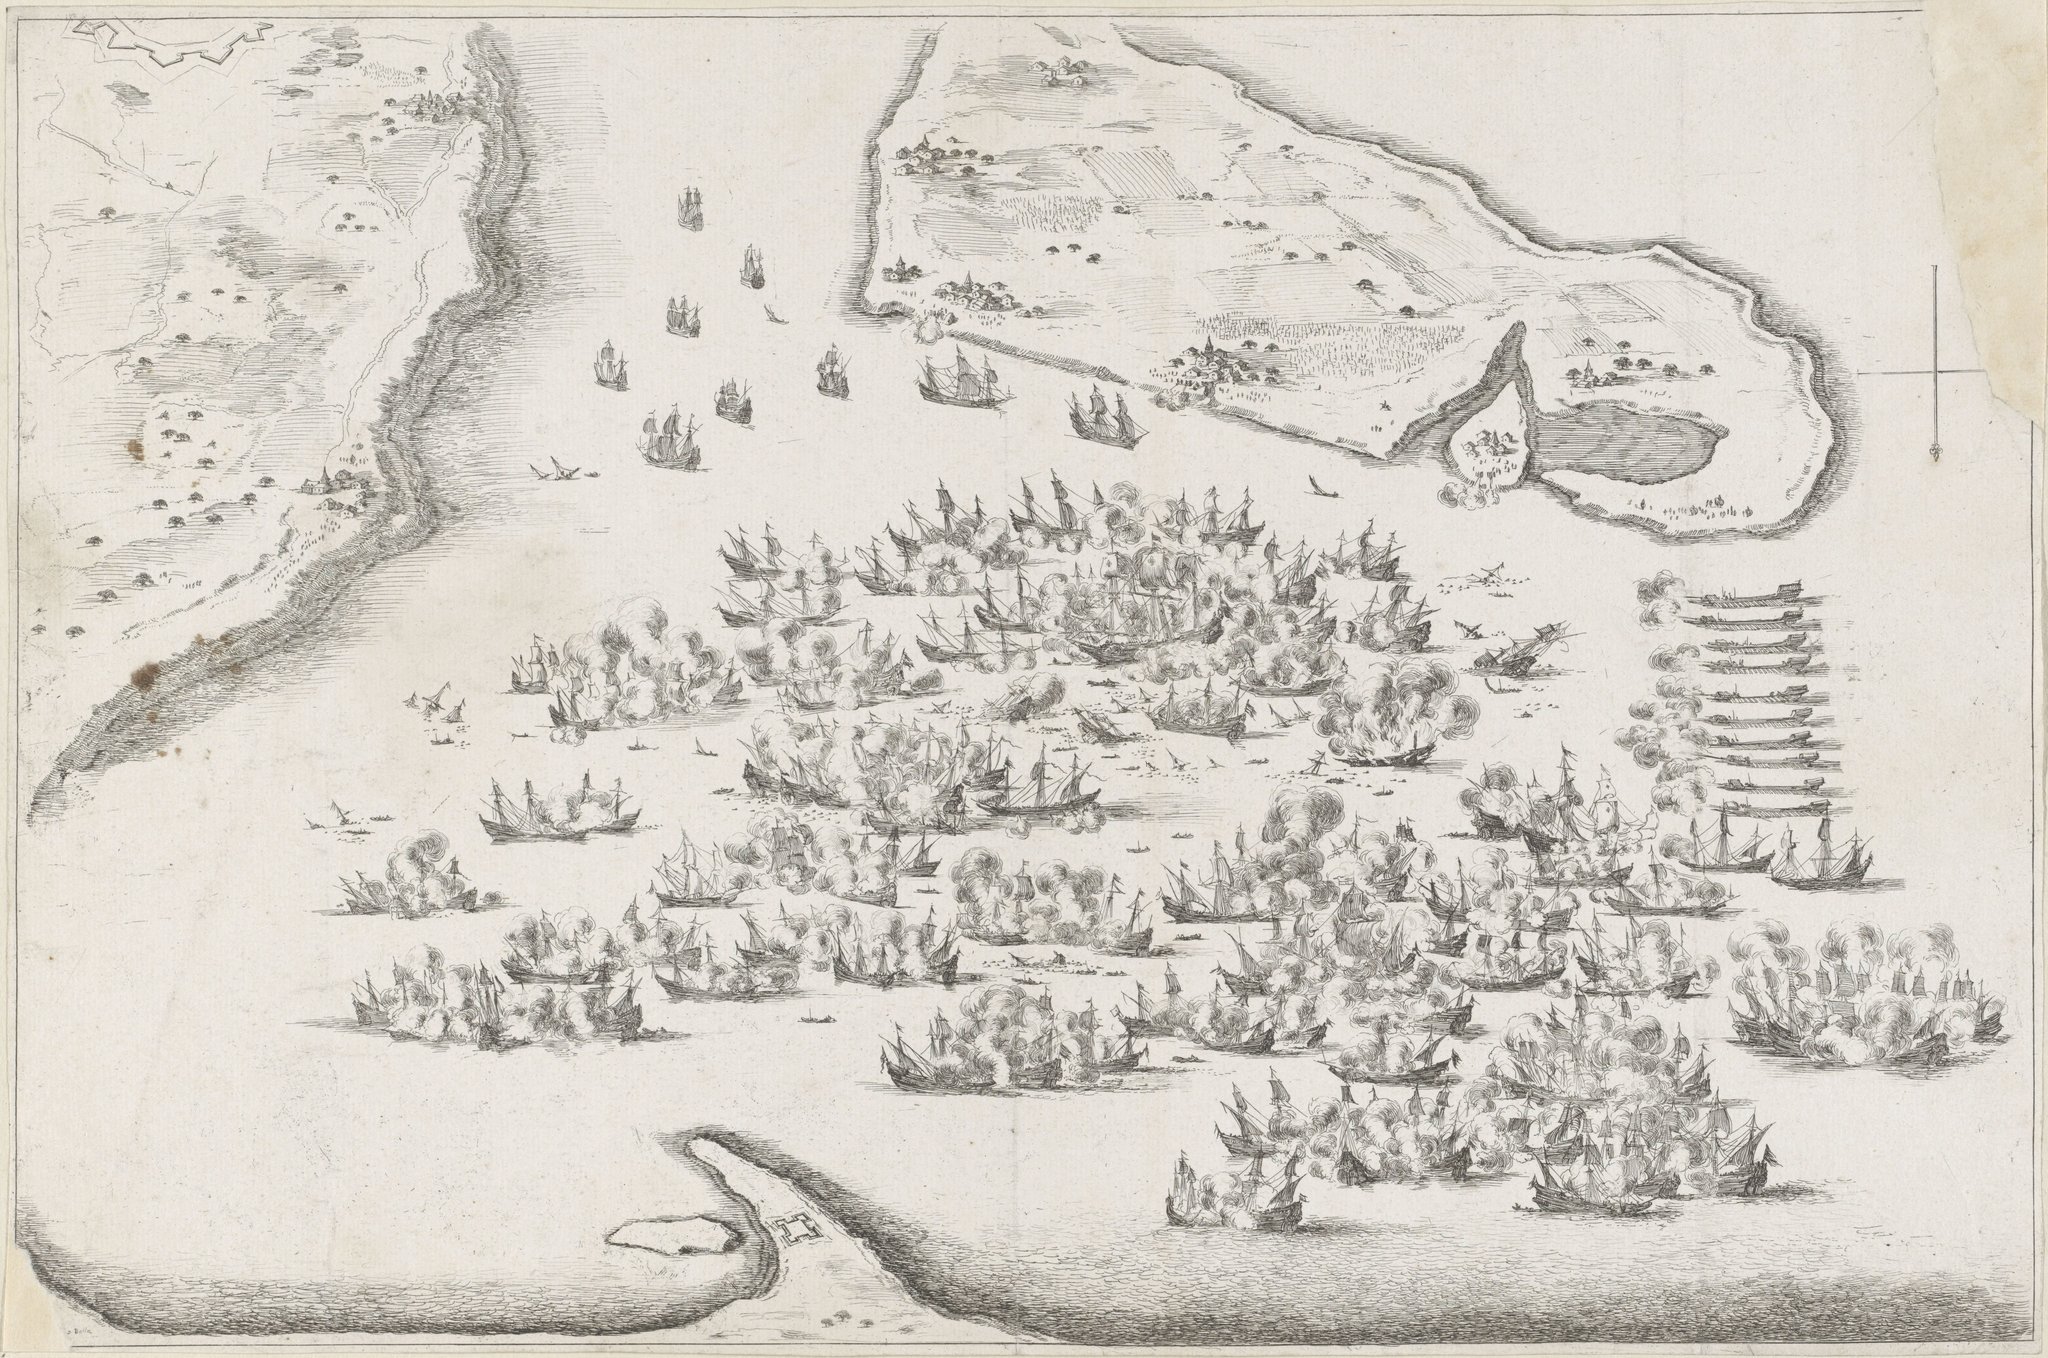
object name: print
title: Illustraties voor: Jean Valdor, Les triomphes de Louis le Juste XIII du nom, 1649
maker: stefano della bella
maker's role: draughtsman, print maker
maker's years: 1610-1664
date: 1620-1664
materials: paper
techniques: etching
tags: battle (+ sailing-ships)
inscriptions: collector's mark: Lugt 240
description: De zeeslag bij La Rochelle op 22 juni 1372 tussen de Engelse vloot onder leiding van de Graaf van Pembroke tegen de geallieerde vloot van Frankrijk en Castilië onder leiding van de Genuees Ambrosio Boccanegra.